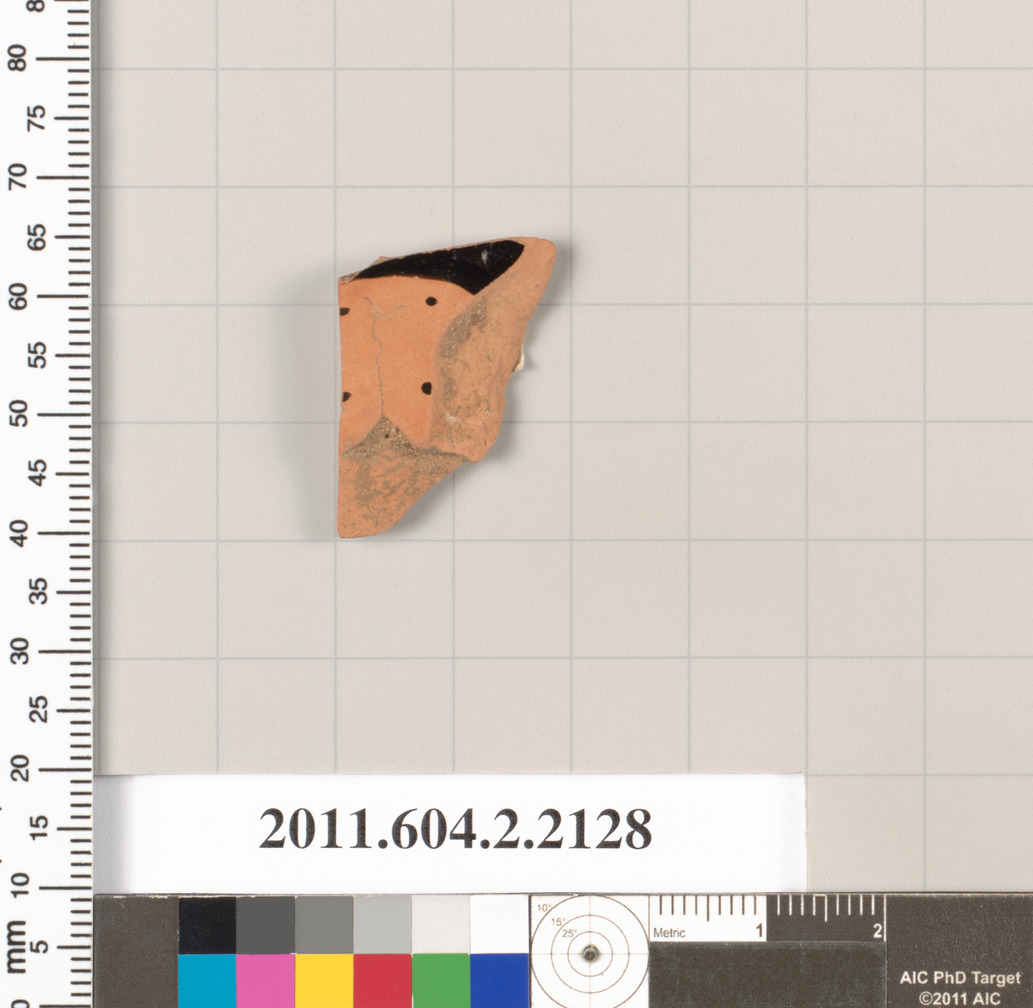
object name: pot fragment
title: Terracotta fragment of a pot; unglazed on the inside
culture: greek, attic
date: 475-451 BCE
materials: terracotta